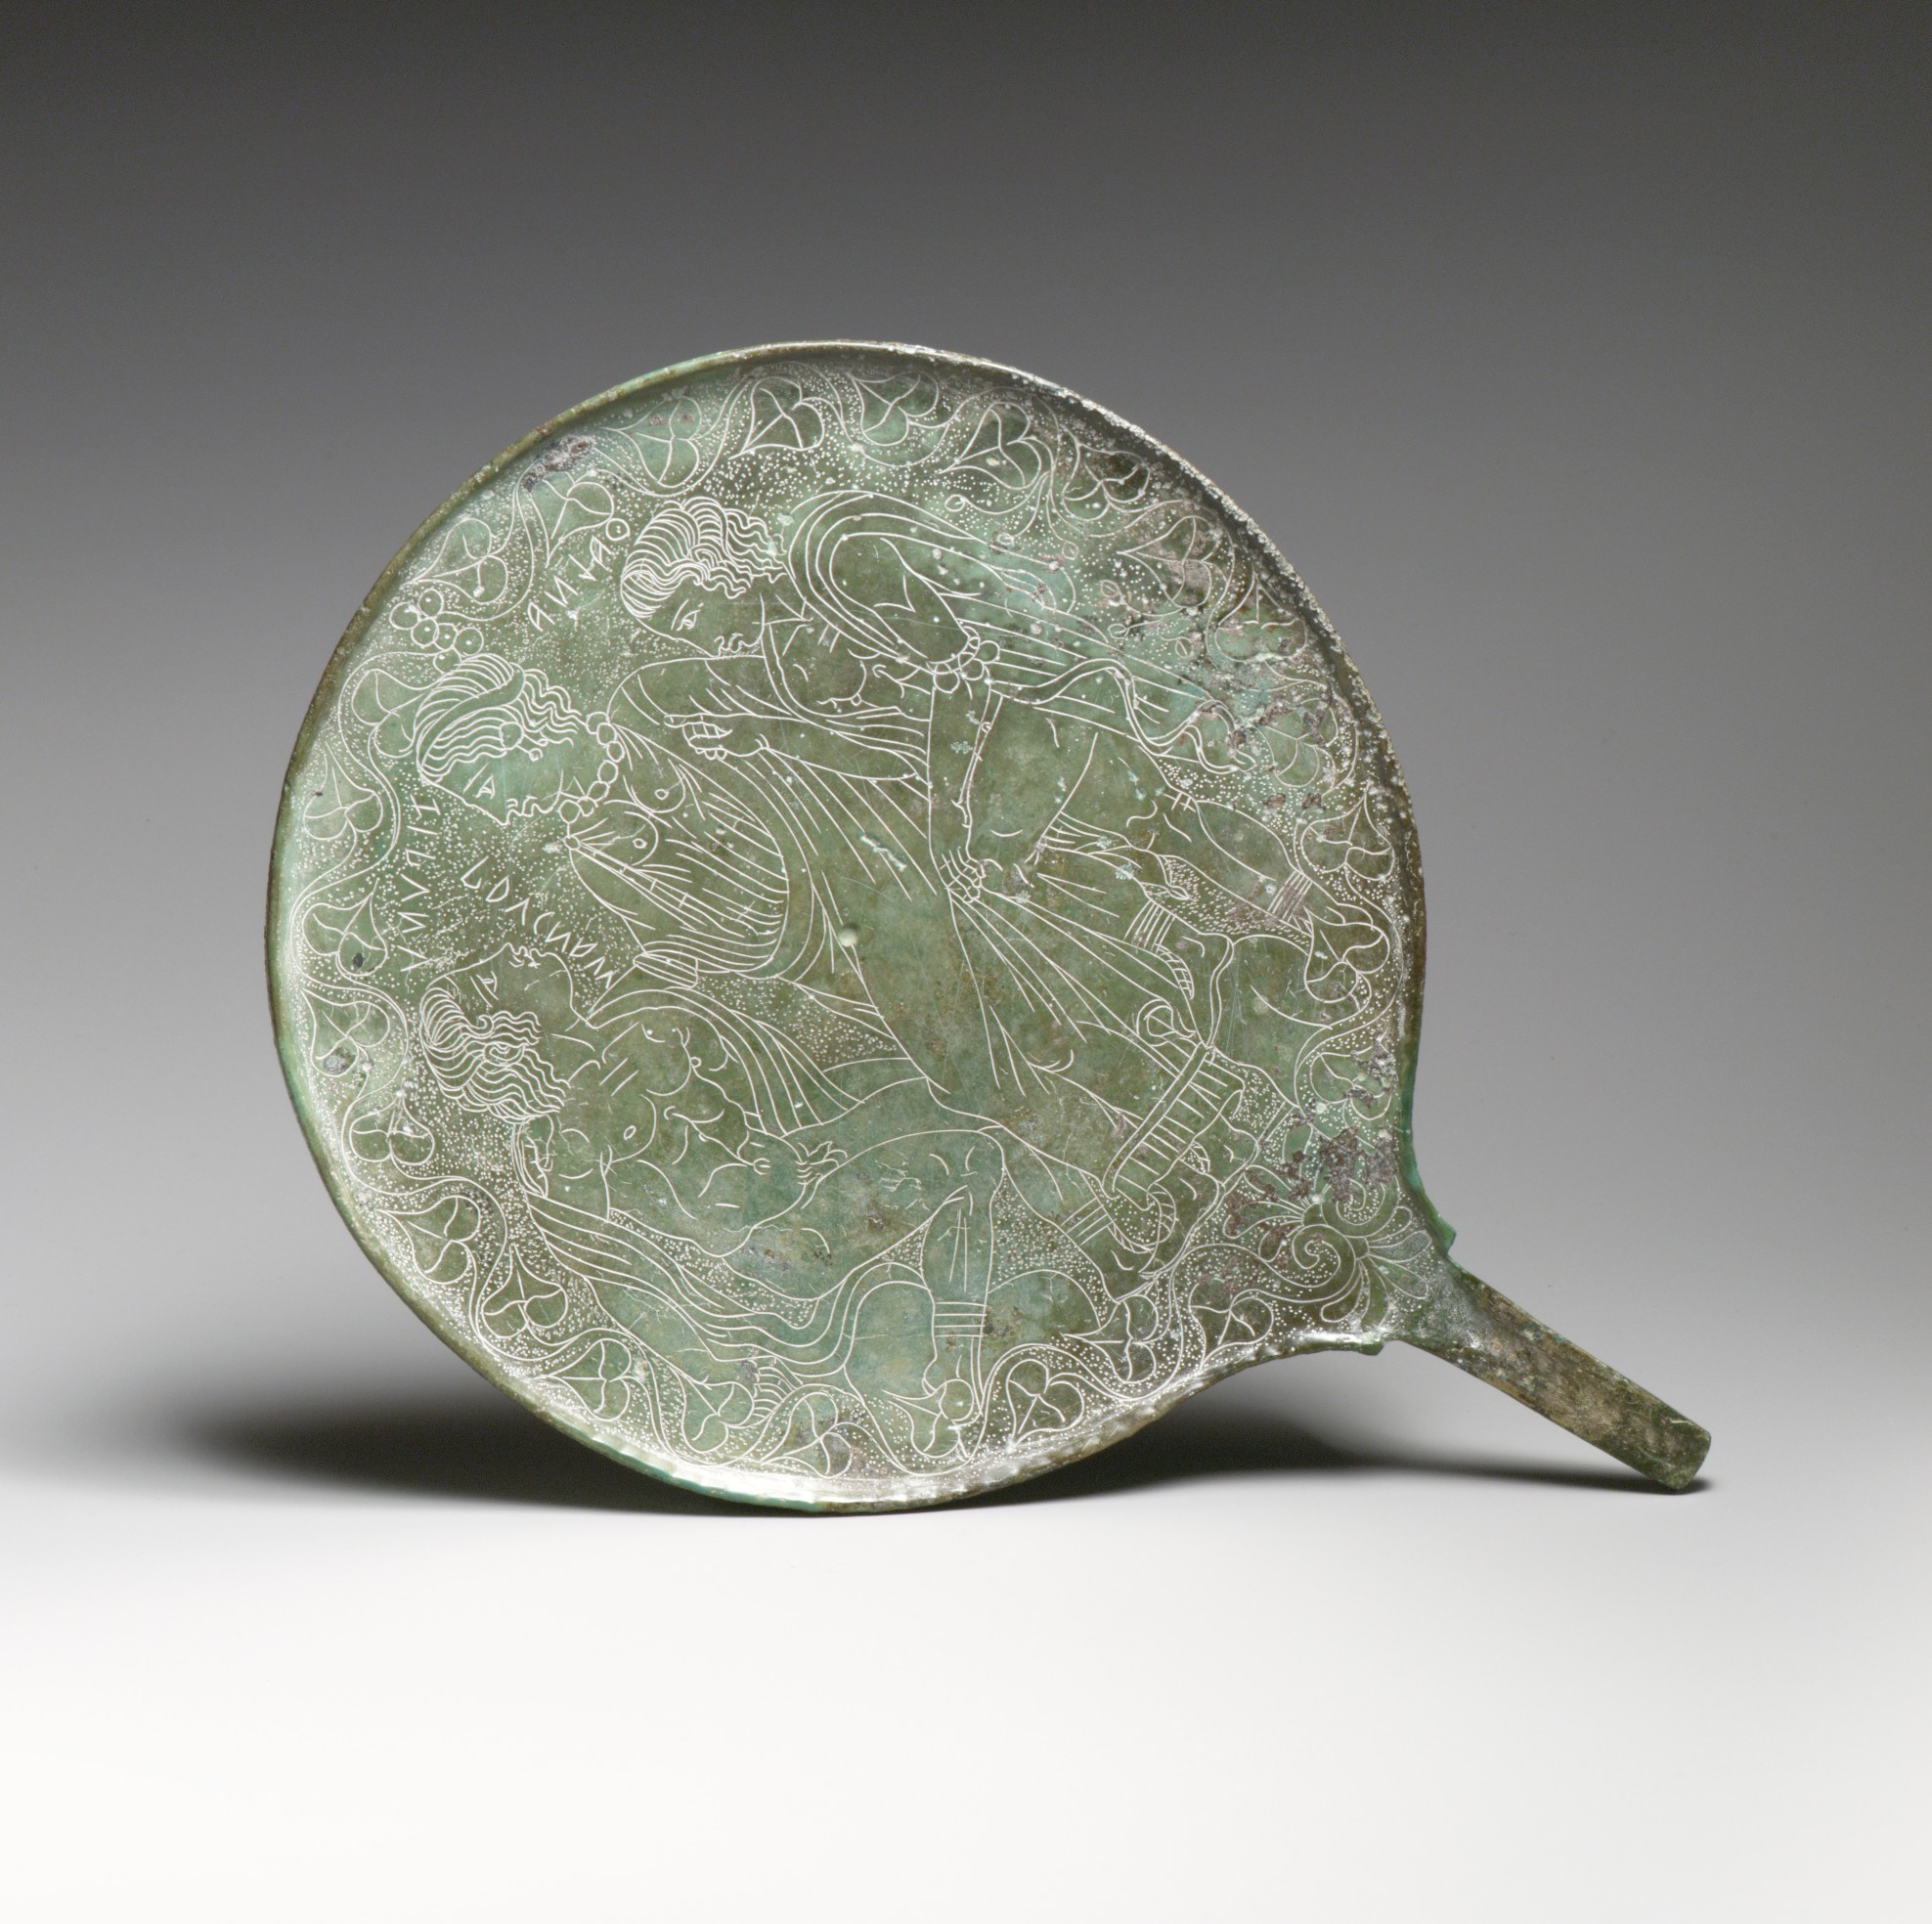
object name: mirror with woman and two men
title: Bronze mirror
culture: etruscan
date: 350-300 BCE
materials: bronze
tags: men,male nudes,goddess